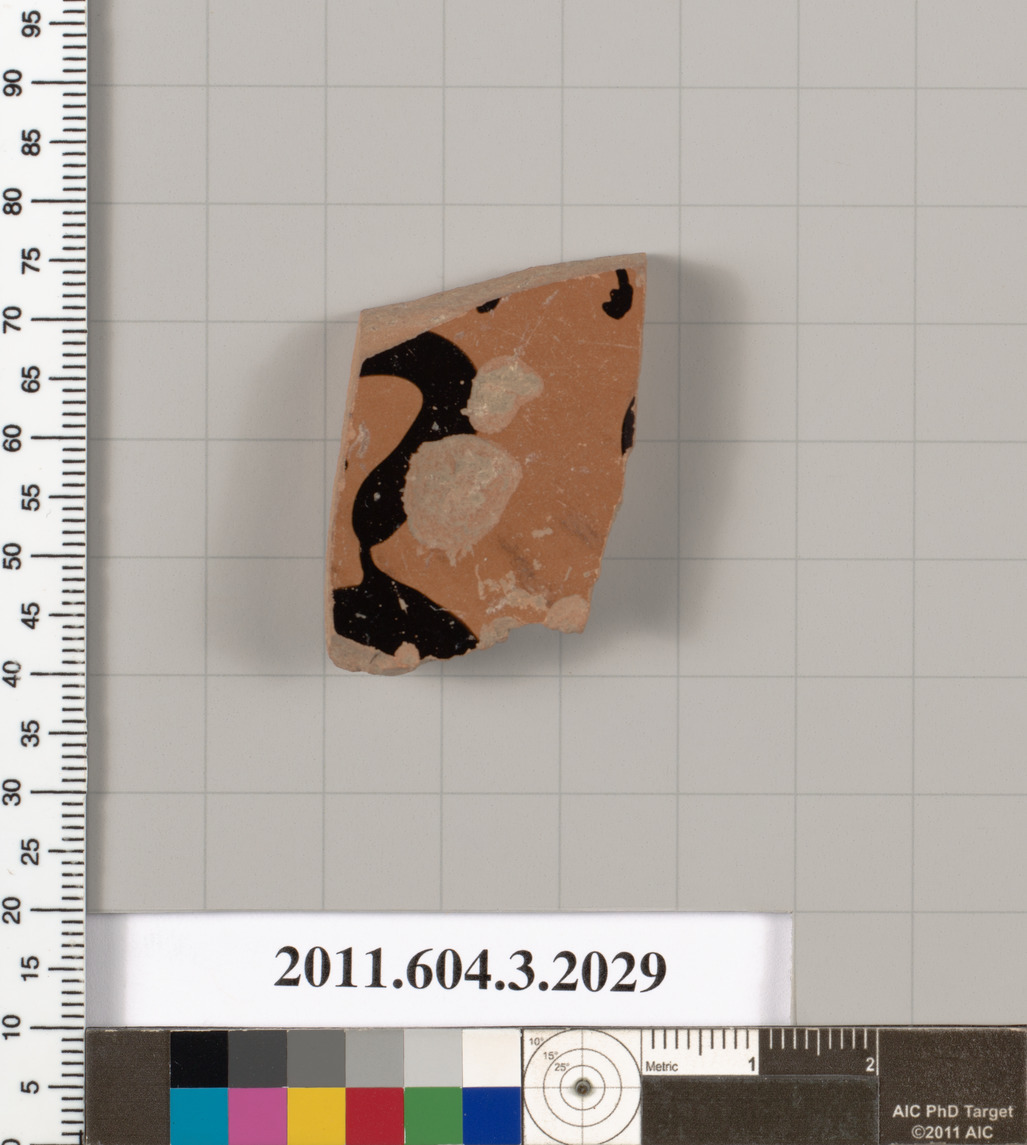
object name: kylix fragment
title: Terracotta fragment of a kylix (drinking cup)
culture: greek, attic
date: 534-468 BCE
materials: terracotta